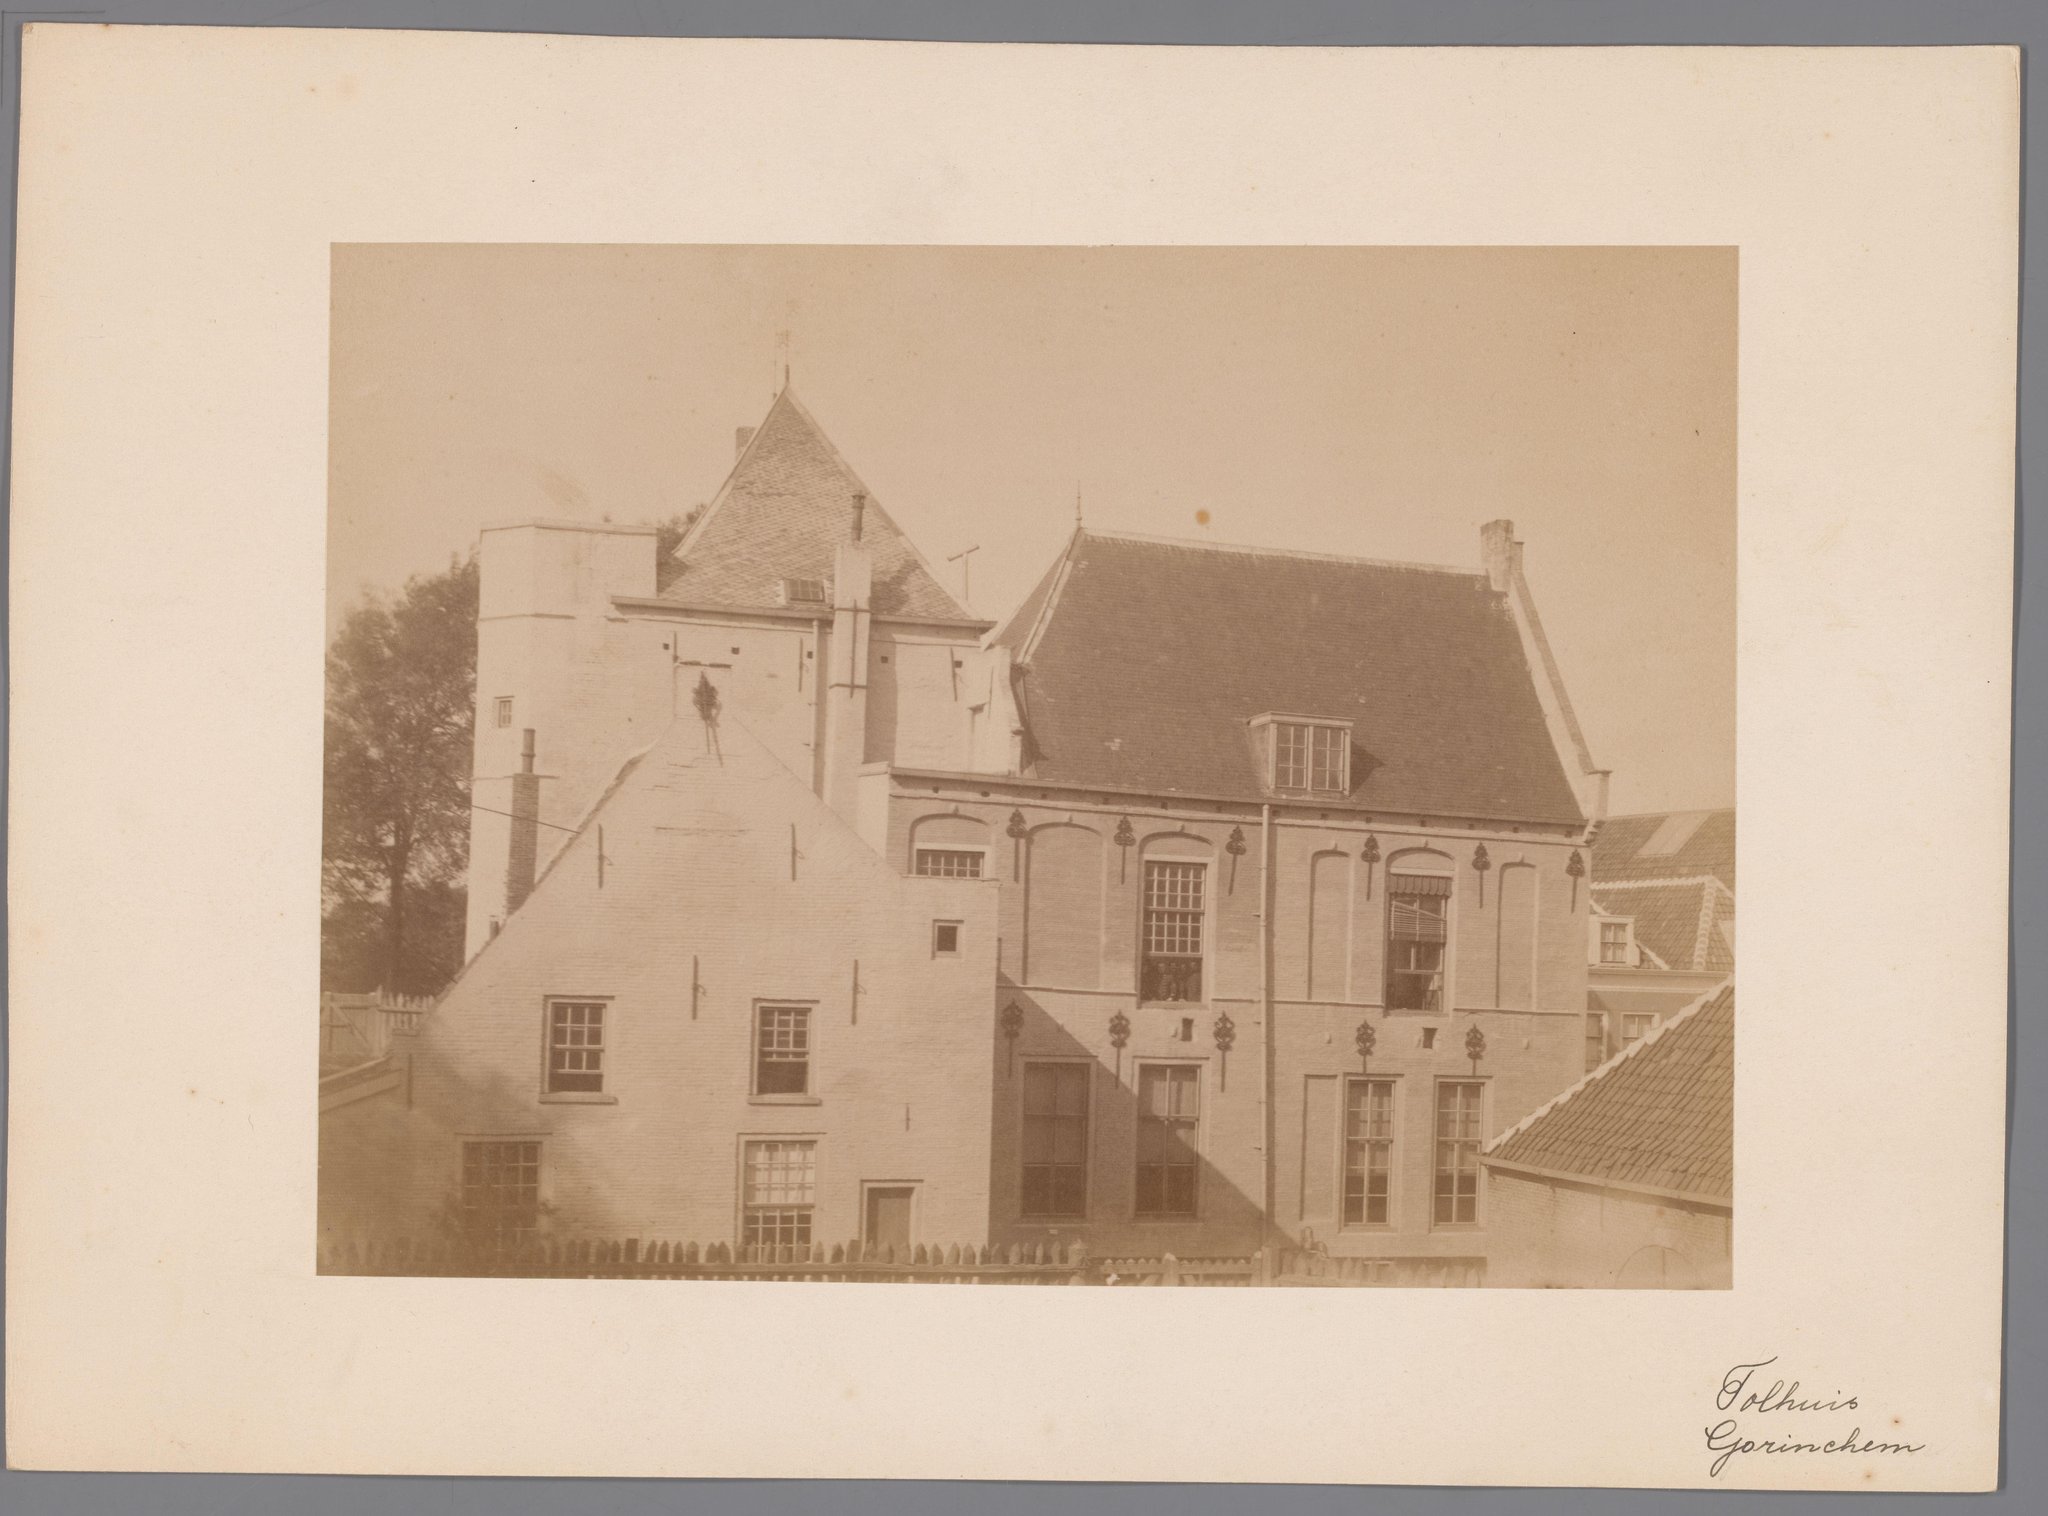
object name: photograph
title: Tolhuis te Gorinchem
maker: anoniem (monumentenzorg)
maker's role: fotograaf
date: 1890-1915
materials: cardboard, photographic support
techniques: albumen print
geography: gorinchem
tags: toll gate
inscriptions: annotation: ‘Gorinchem/ Tolhuis’, annotation: ‘Tolhuis/ Gorinchem’